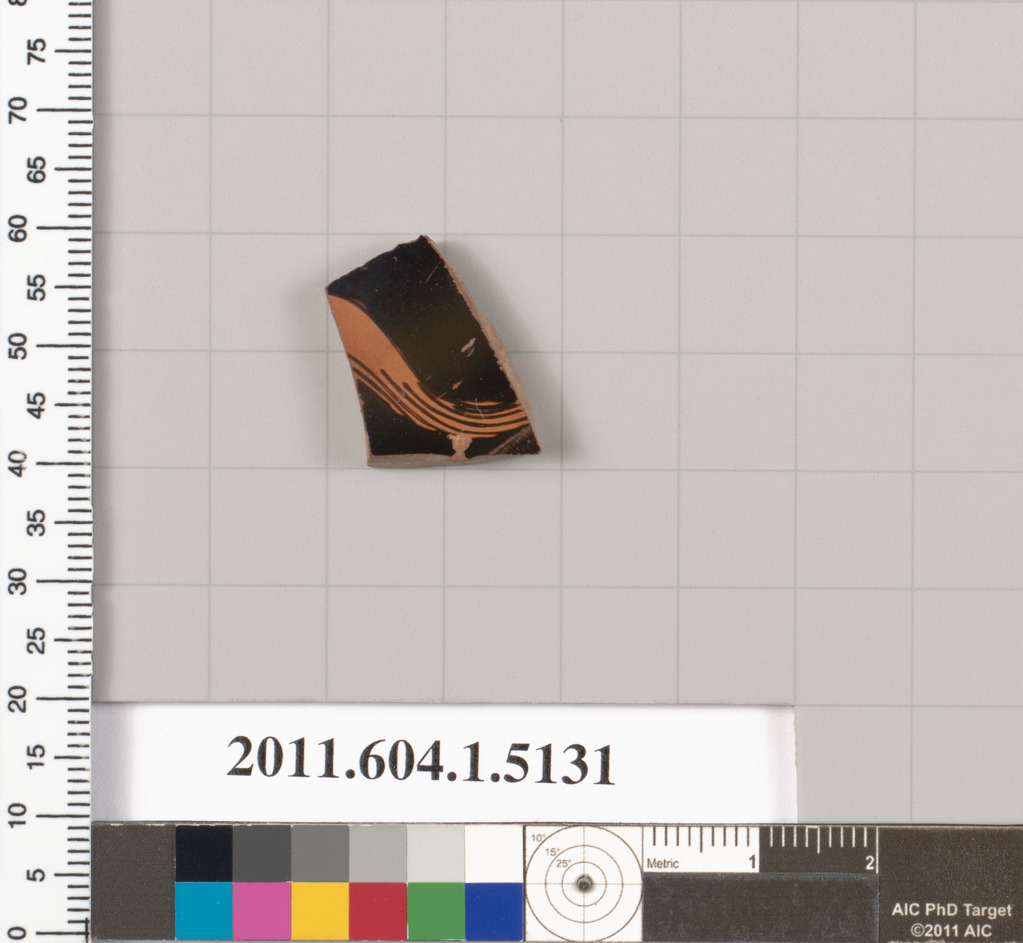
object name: kylix fragment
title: Terracotta fragment of a kylix (drinking cup)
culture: greek, attic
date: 490-480 BCE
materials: terracotta